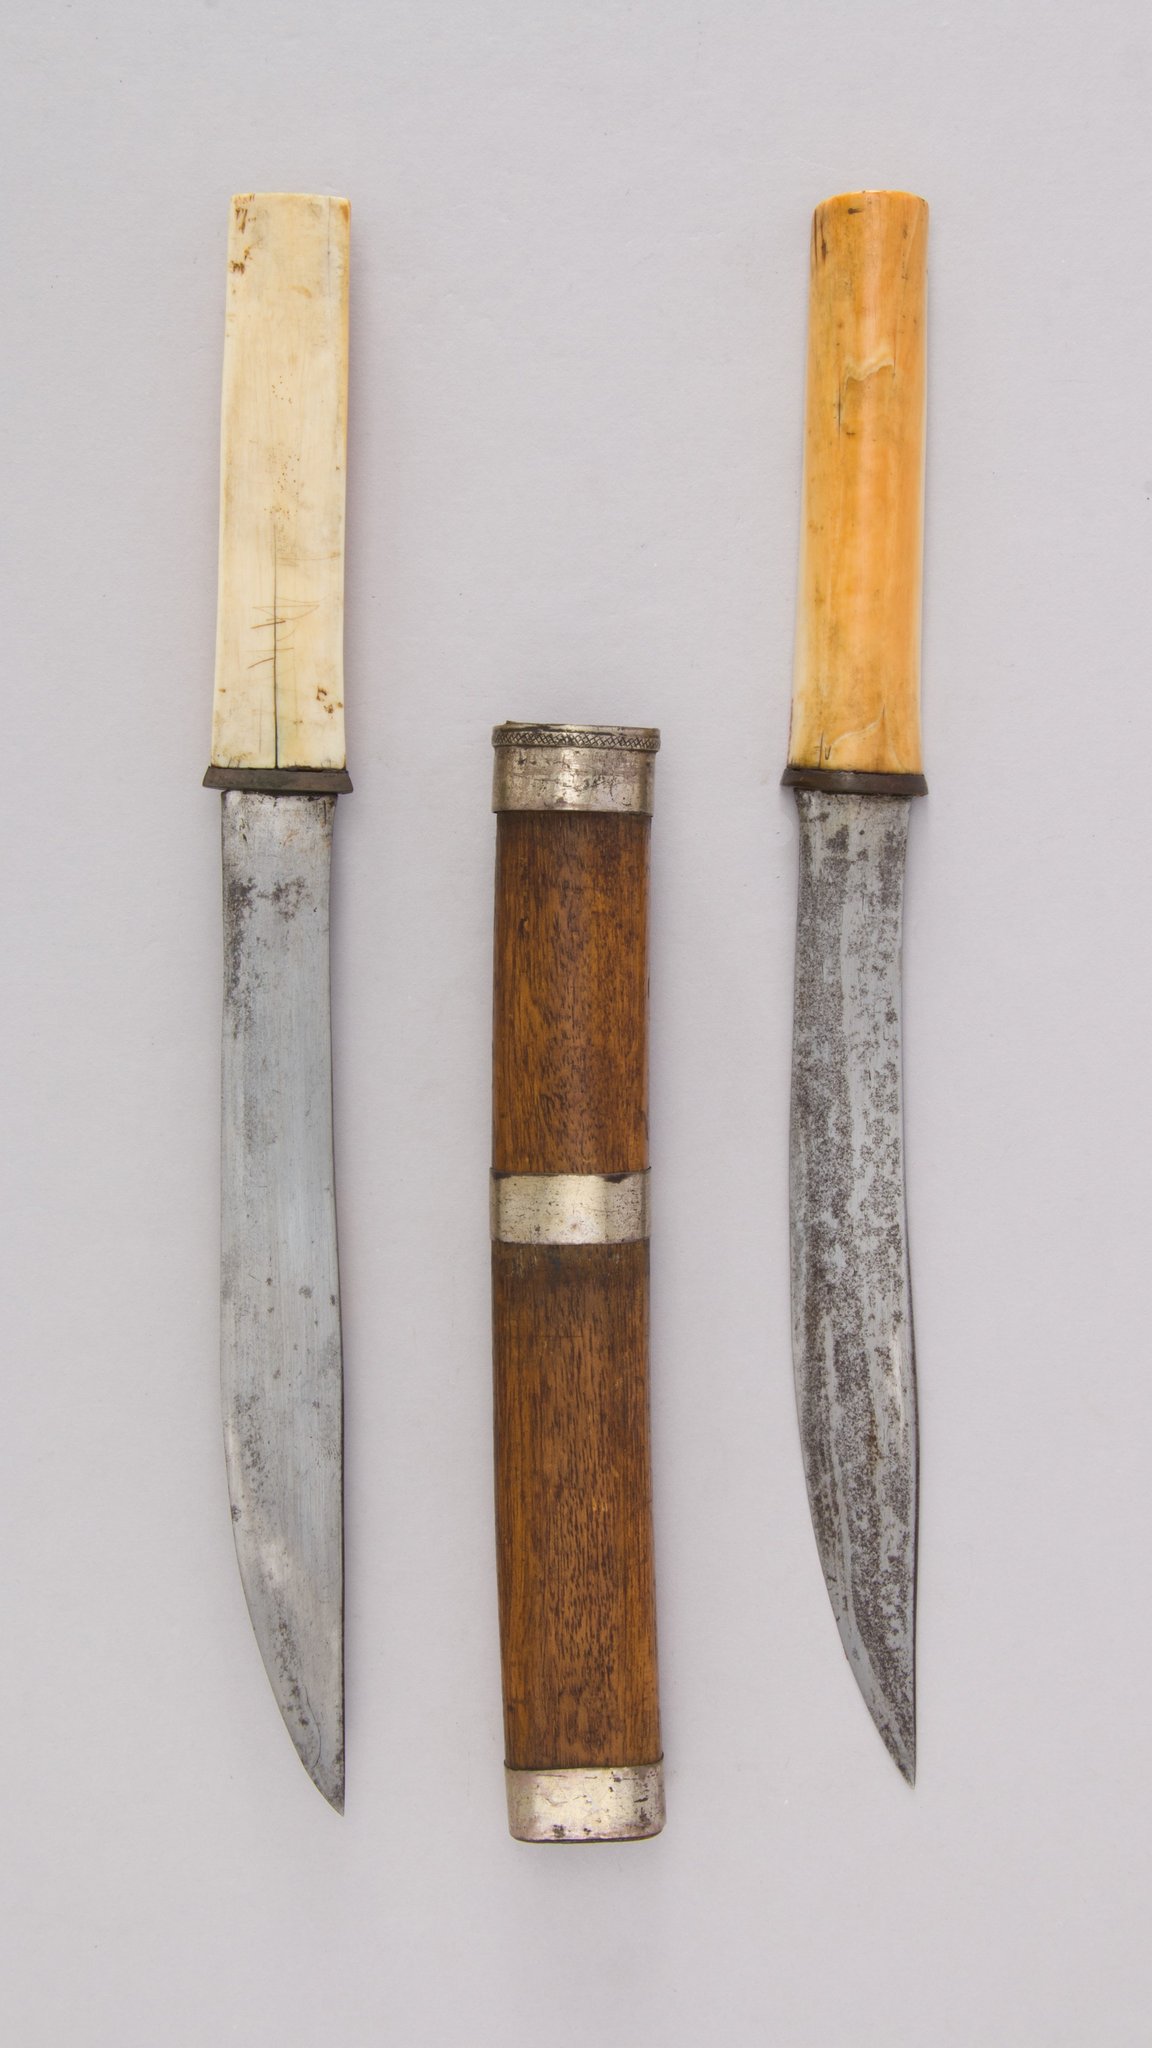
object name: pair of knife dha with sheath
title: Pair of Knives (Dha) with Sheath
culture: burmese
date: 1801-1900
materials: ivory, silver, steel, wood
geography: burma